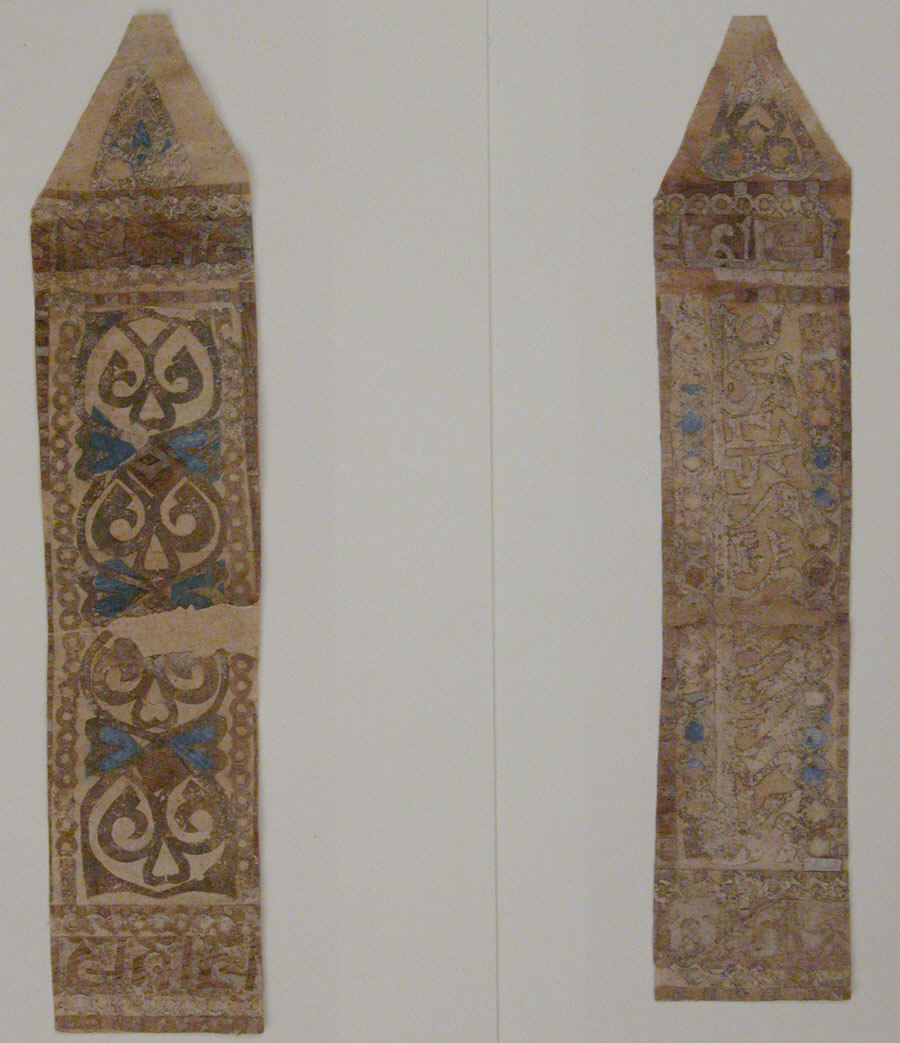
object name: paper cut out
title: Paper Cut-Out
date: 901-1000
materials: paper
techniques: cutting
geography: egypt